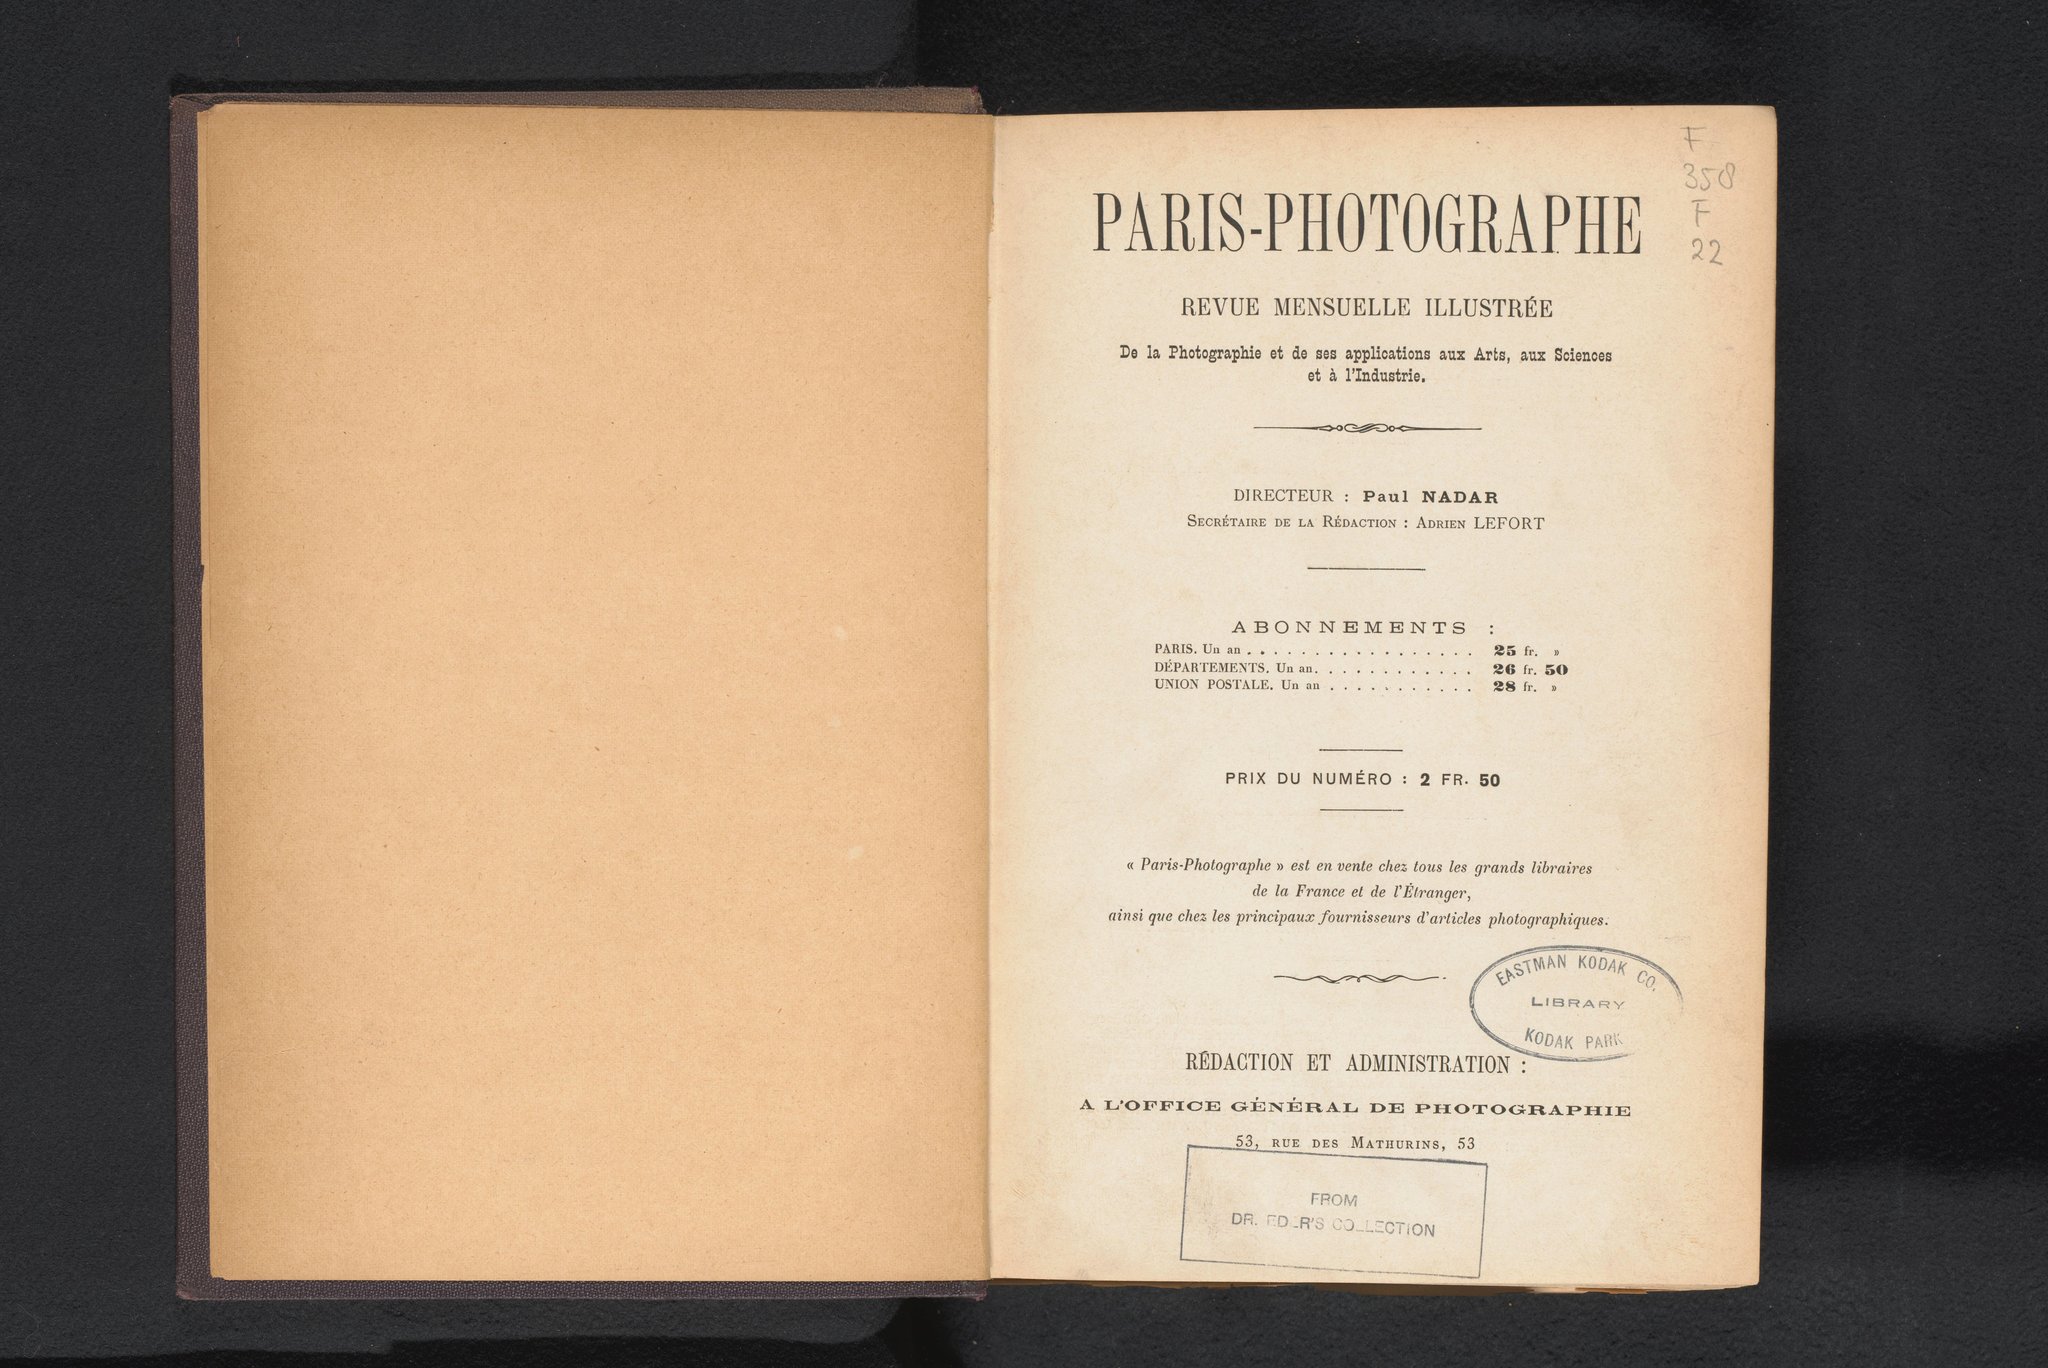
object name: magazine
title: Paris-Photographe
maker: paul nadar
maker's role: fotograaf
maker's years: 1856-1939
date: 1892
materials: cardboard, linen, paper, photographic support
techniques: albumen print, photograph, printing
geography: france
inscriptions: number: ‘Accession No. 6577’, name: ‘Eastman Kodak Co. Library Kodak Park’, name: ‘From DR. Eder's Collection’